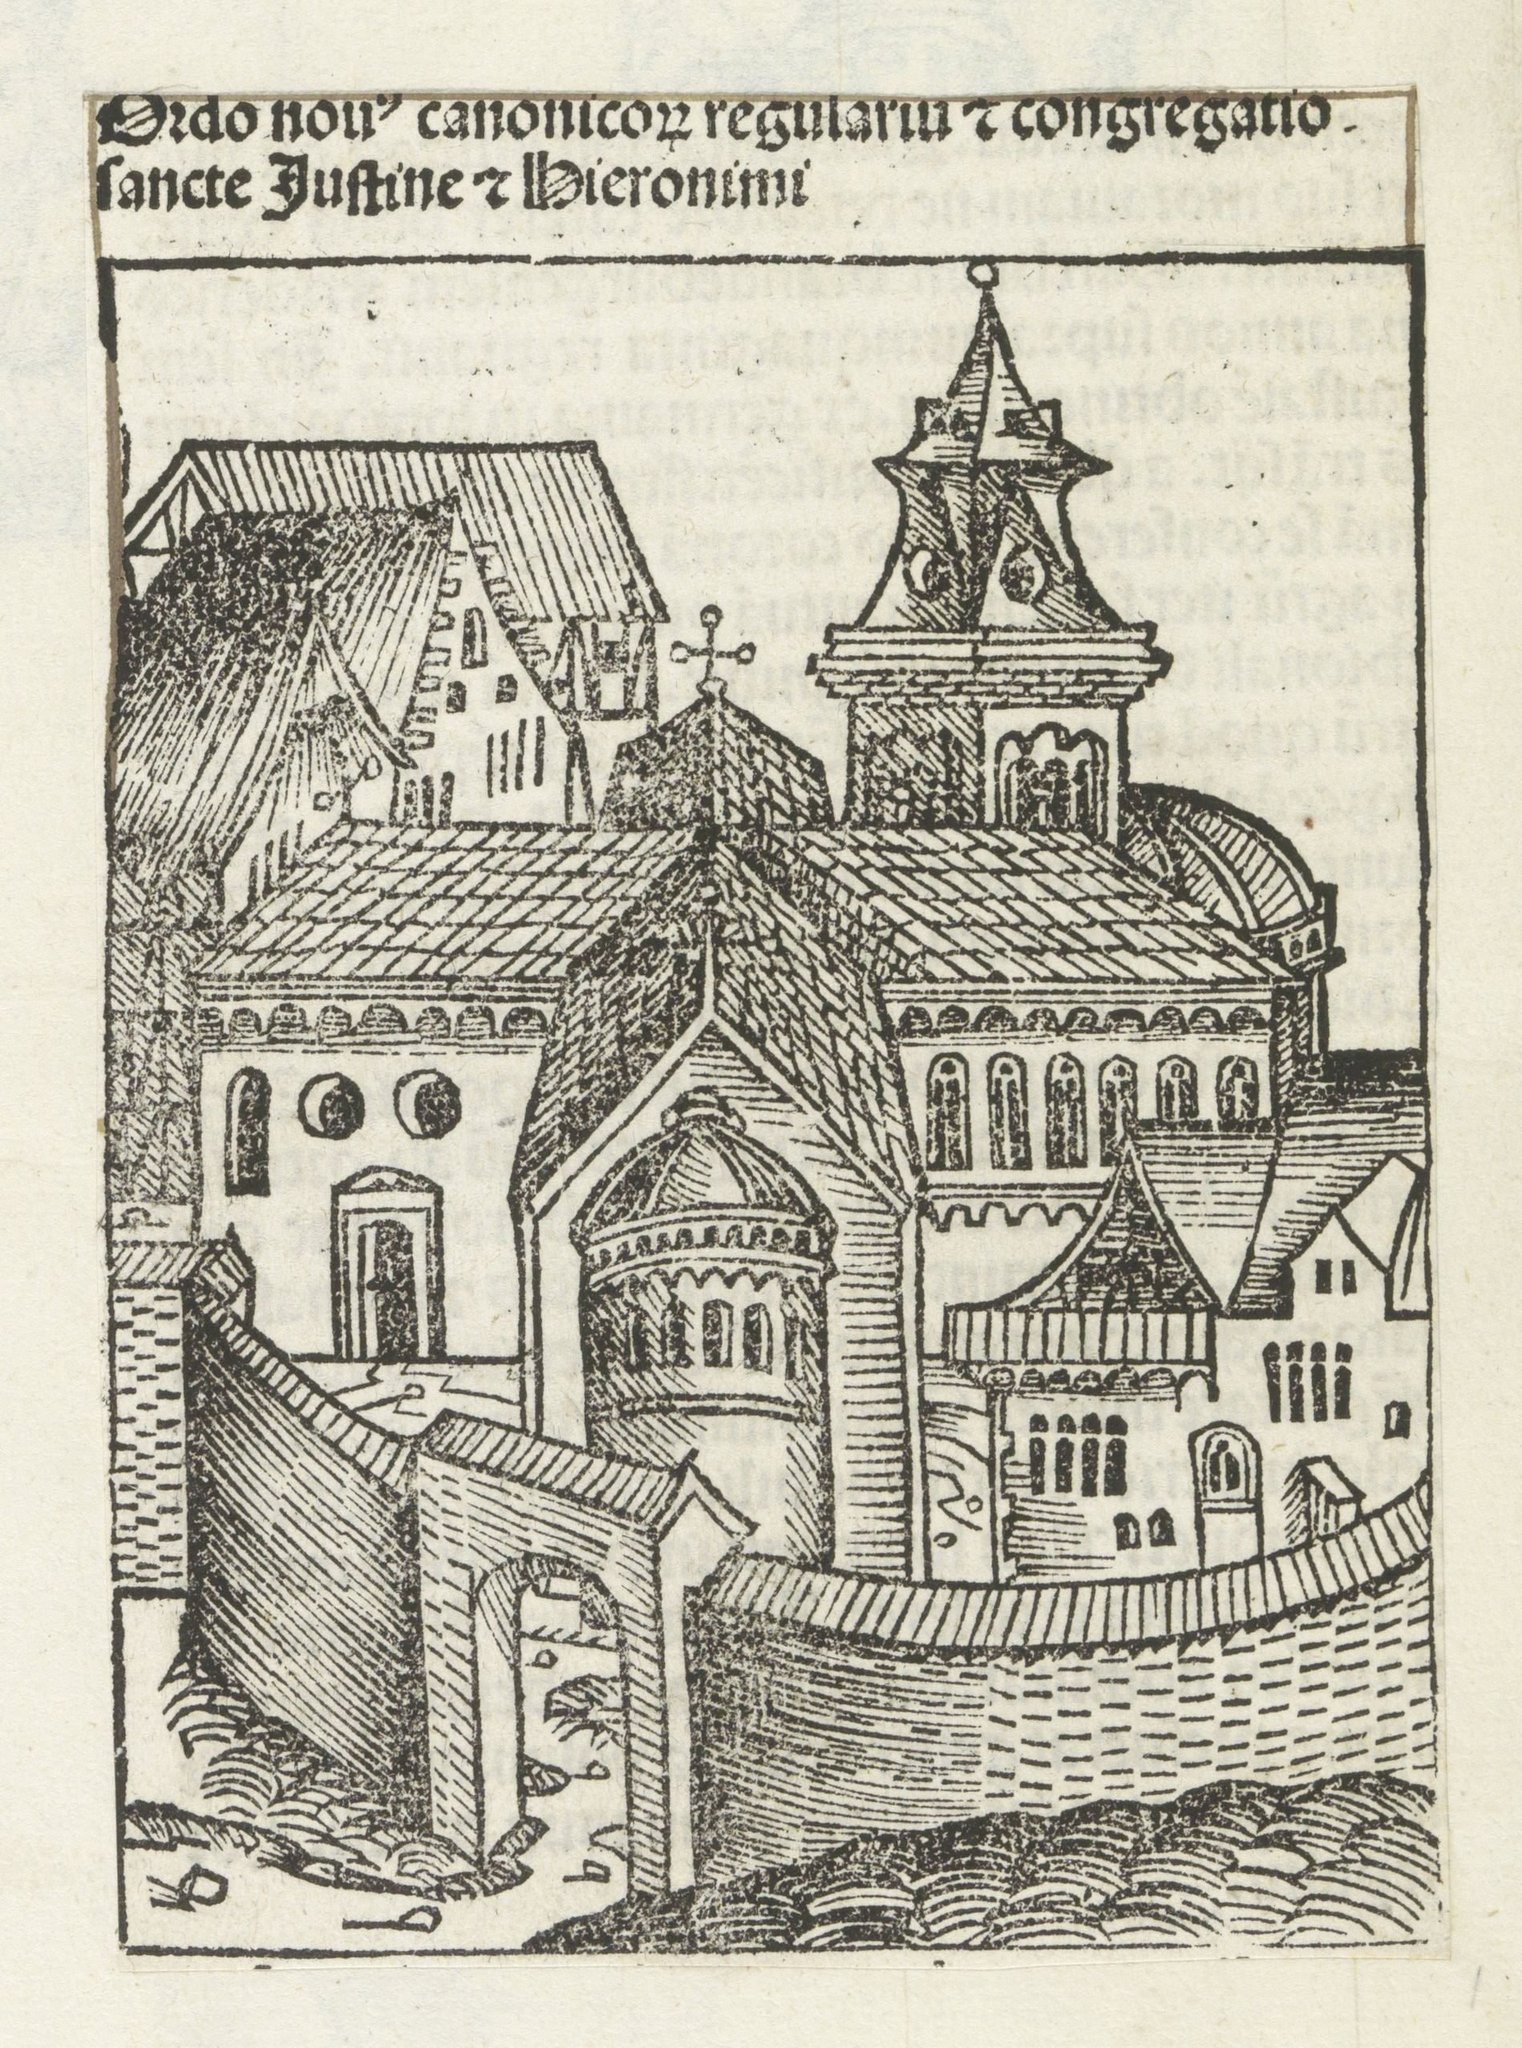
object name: book illustration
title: Liber Chronicarum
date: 1493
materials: paper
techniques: letterpress printing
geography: nuremberg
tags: abbey, monastery, convent ~ roman catholic church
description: De houtsnede wordt herhaaldelijk gebruikt als boekillustratie in de Liber Chronicarum (of Neurenbergkroniek) van Hartmann Schedel, verschenen in het Latijn en Duits in 1493. Zie de Latijnse uitgave, folio 239v.